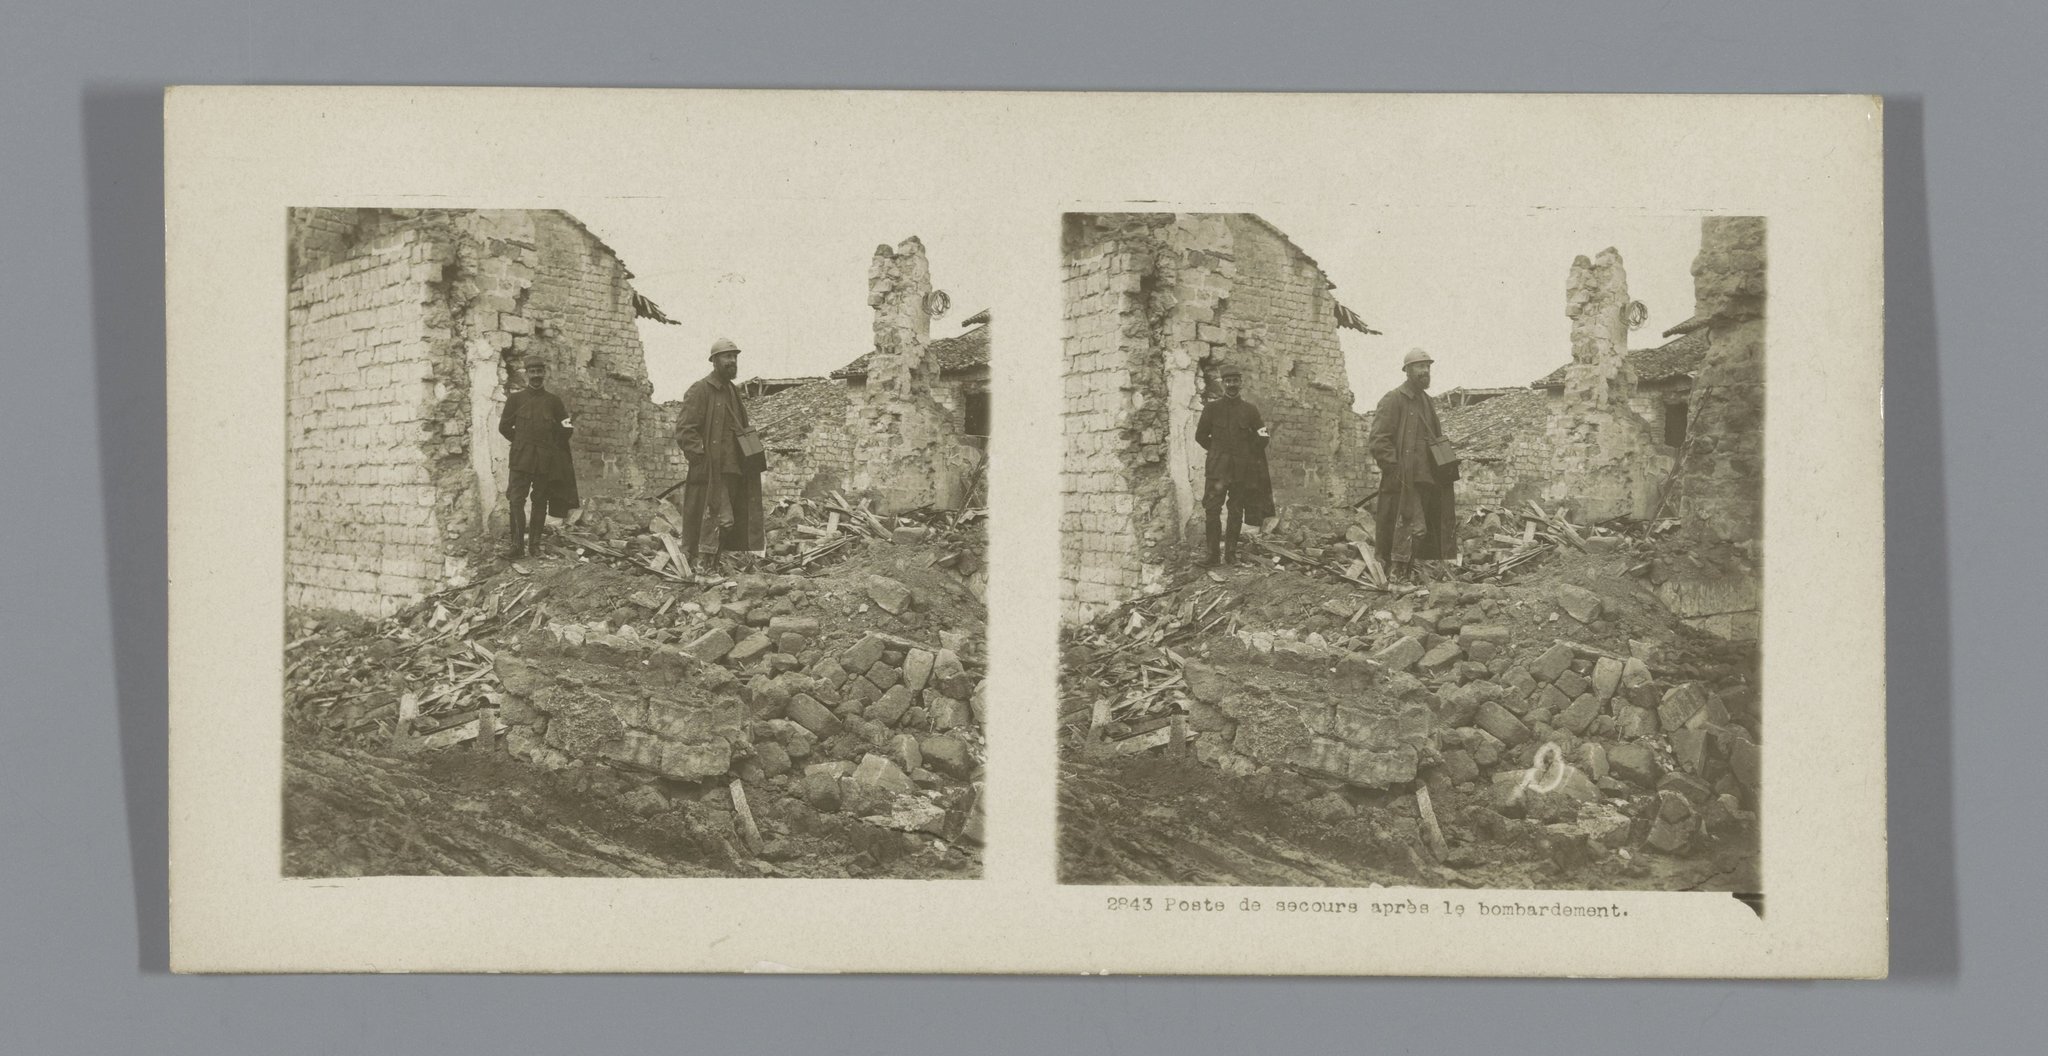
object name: stereograph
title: Poste de secours apres le bombardement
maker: Anonymous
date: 1914-1918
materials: cardboard, photographic support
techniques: gelatin silver print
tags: ruin of a building ~ architecture, hygienic and medical provisions (military)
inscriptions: number: ‘2843’